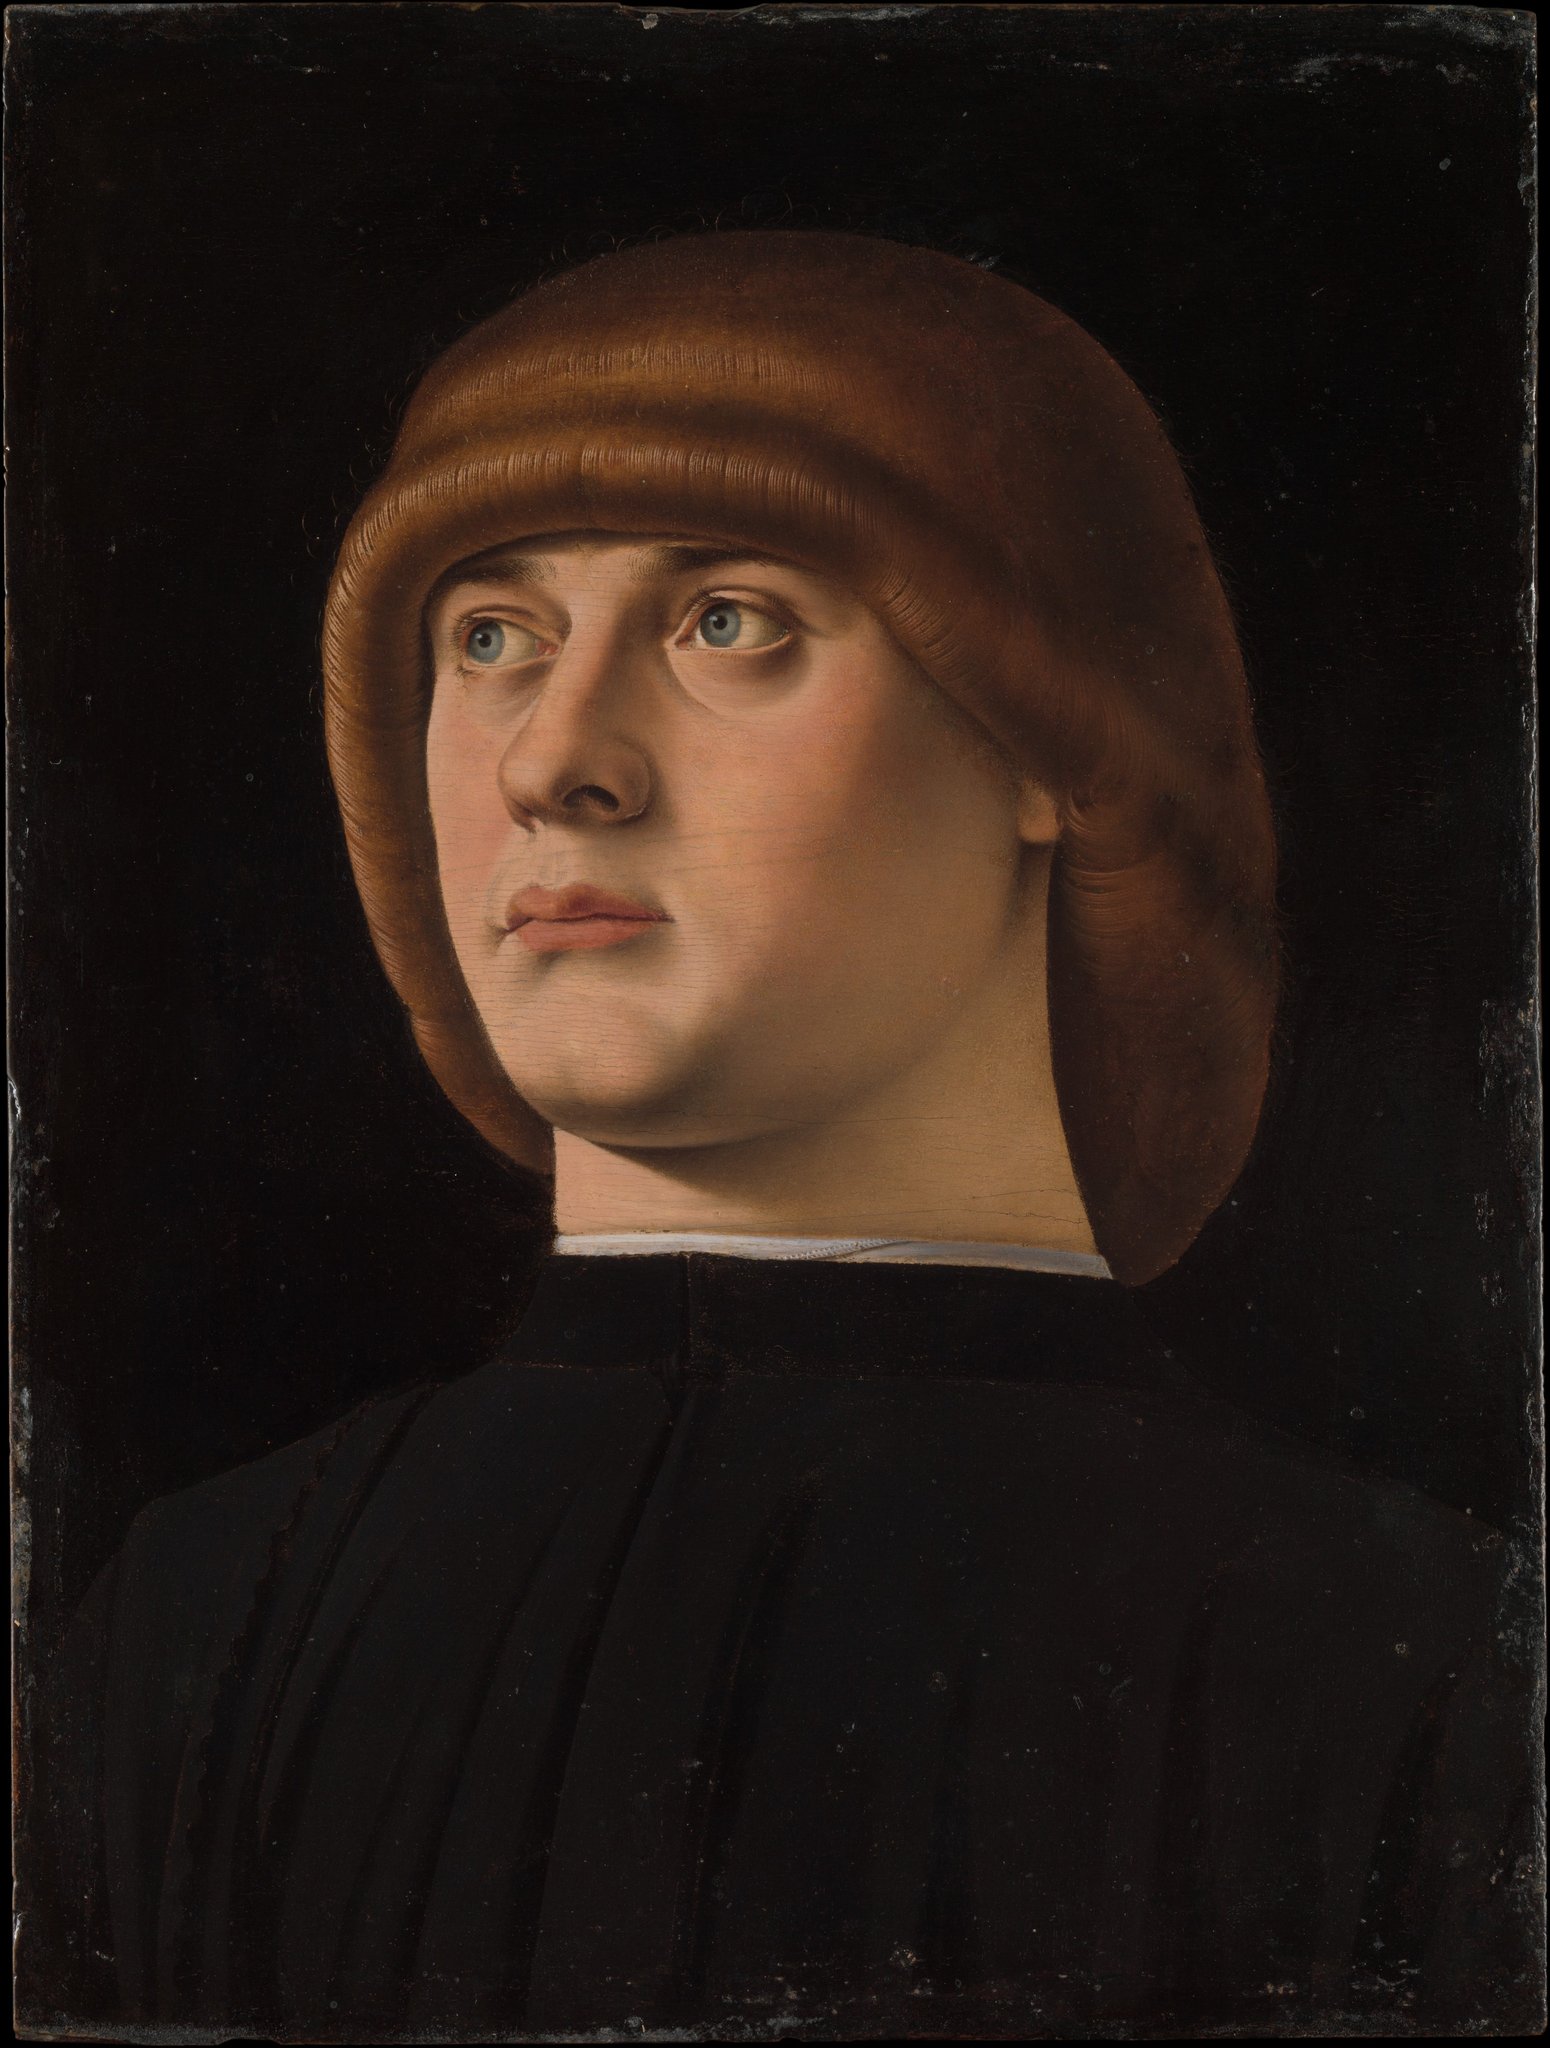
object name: painting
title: Portrait of a Young Man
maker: jacometto (jacometto veneziano)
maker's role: artist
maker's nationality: italian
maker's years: 1472-1498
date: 1480-1489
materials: oil, wood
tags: men,portraits